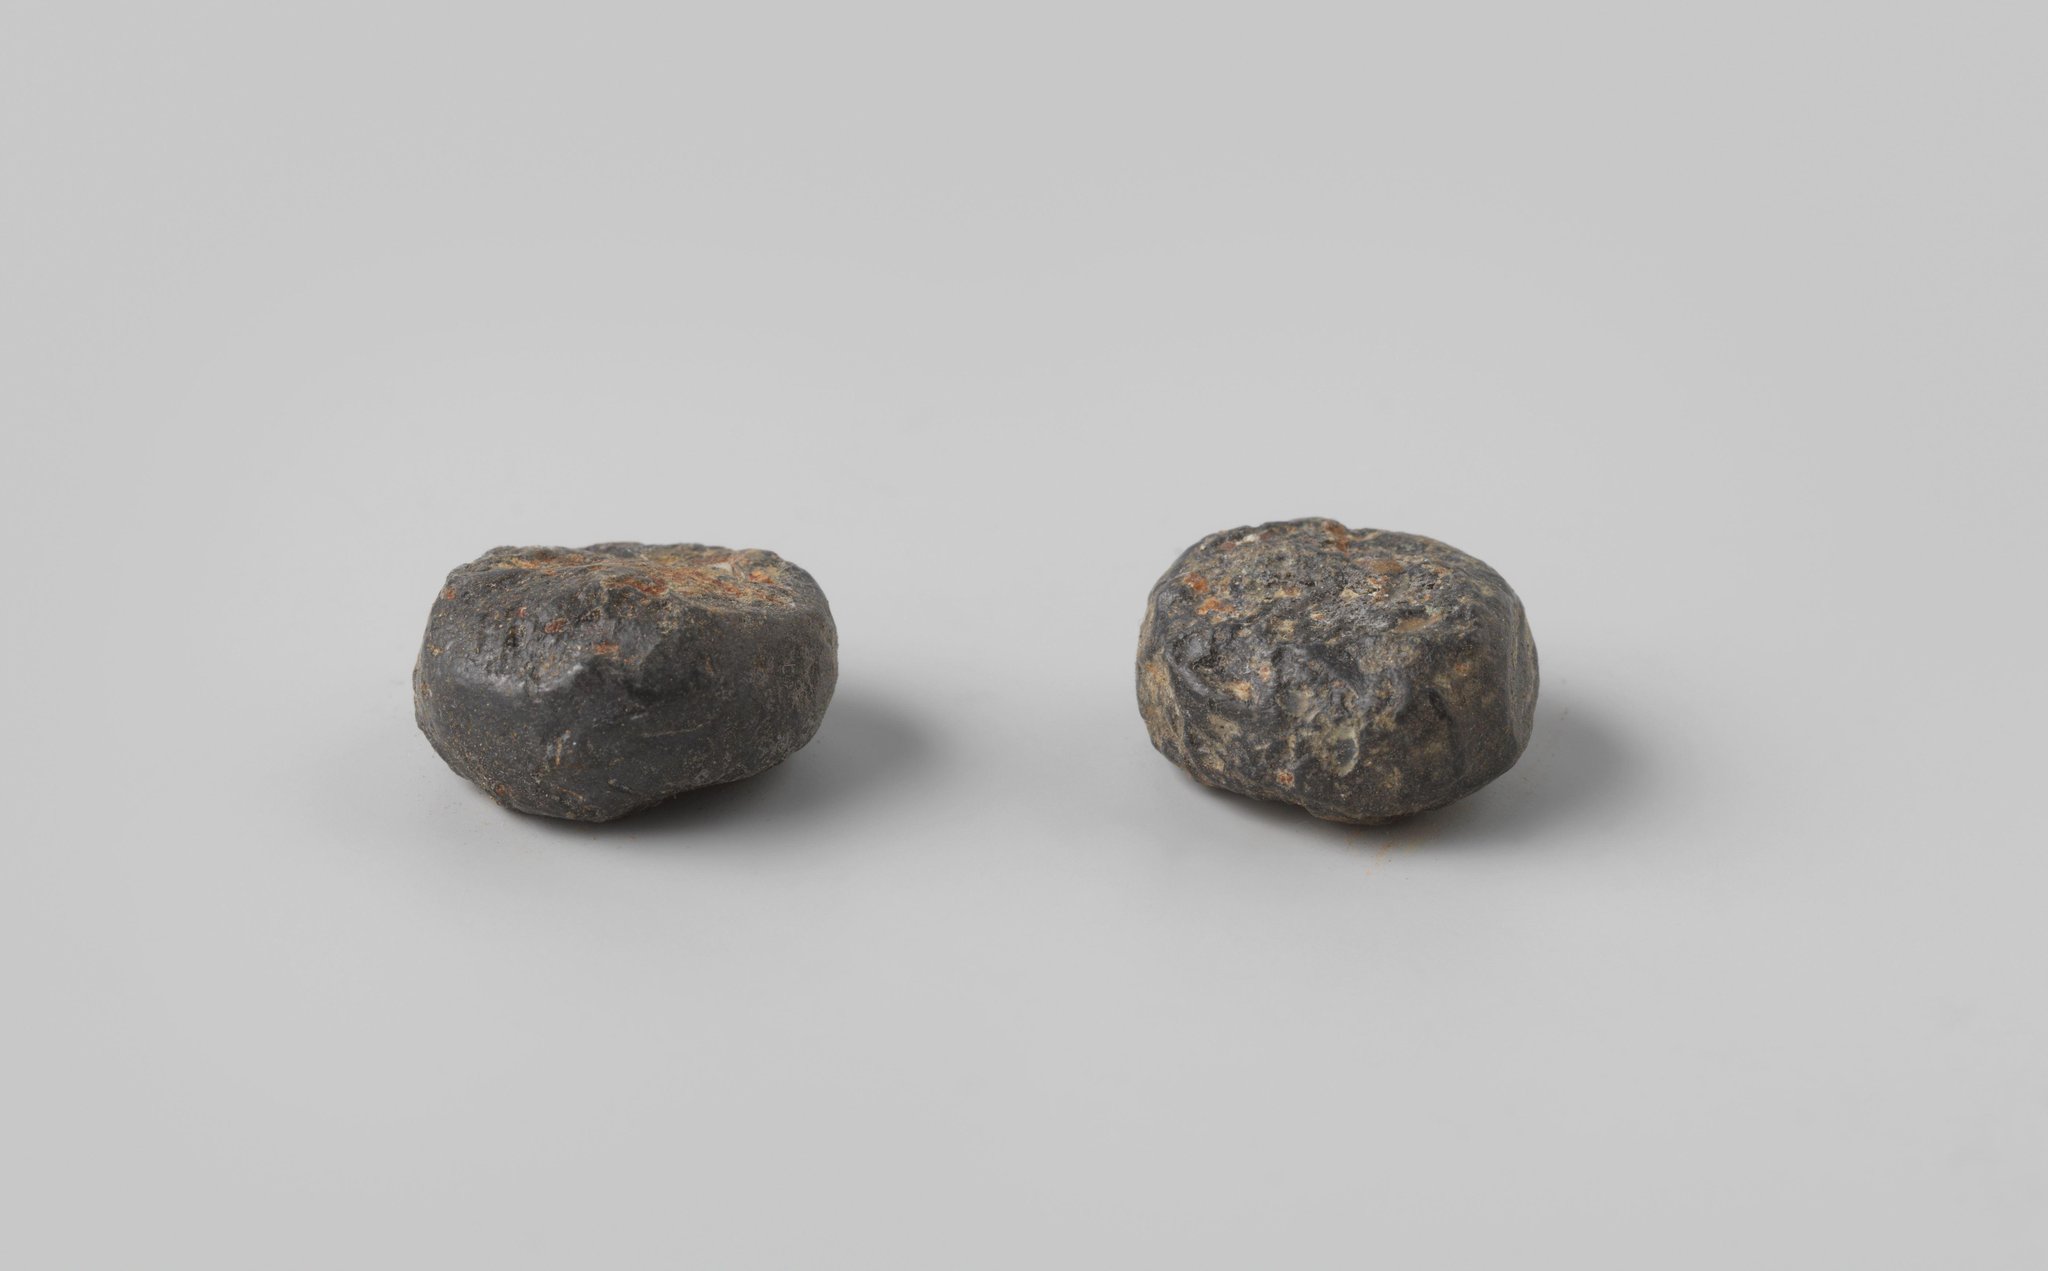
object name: musketkogel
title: Musketkogels uit het wrak van de Oost-Indiëvaarder Hollandia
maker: Anonymous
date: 1700-1743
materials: lead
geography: netherlands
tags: verenigde oostindische compagnie, hollandia (schip), annet